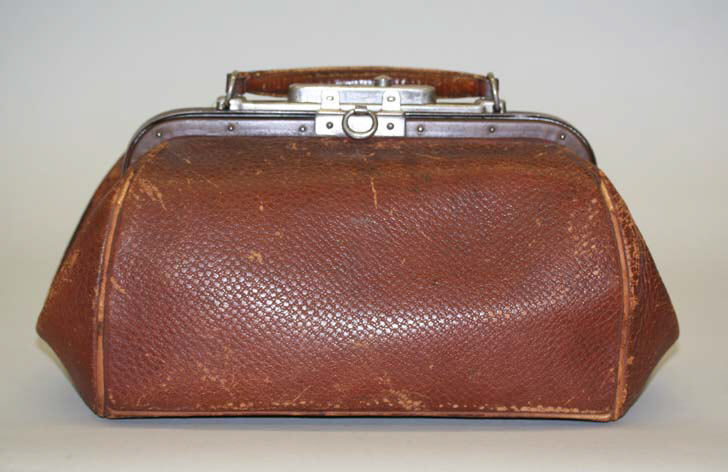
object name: satchel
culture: american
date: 1834-1866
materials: leather, metal